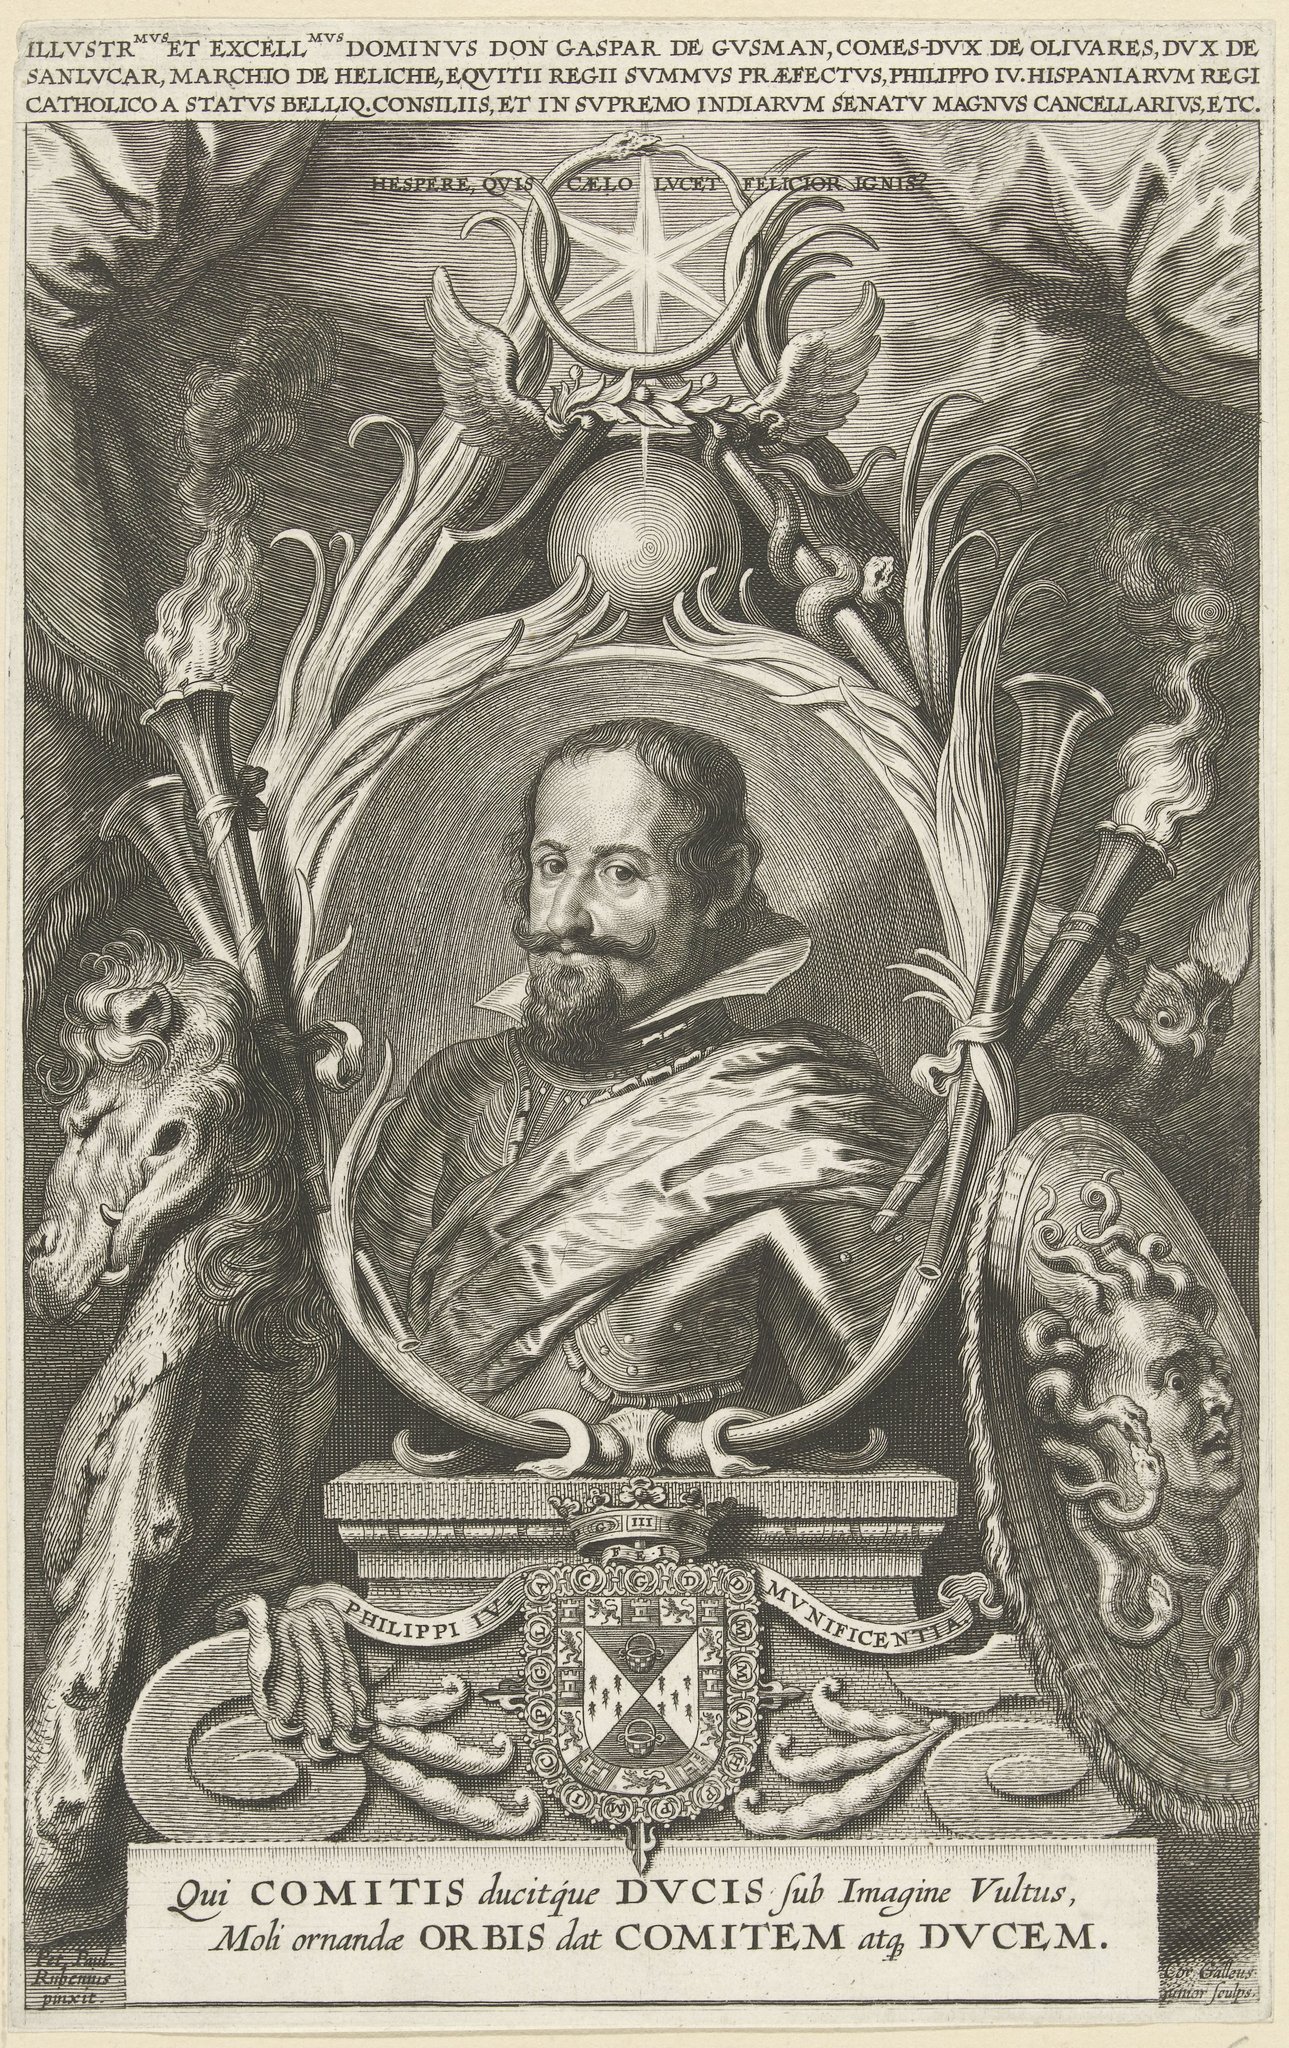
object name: print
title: Portret van Gaspar de Gusmán, graaf van Olivares, hertog van St. Lucar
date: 1638-1650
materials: paper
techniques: engraving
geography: antwerp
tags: gaspard de gusmán (graaf van olivares, hertog van san lucar)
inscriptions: collector's mark: Lugt 240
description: Portret van Gaspar de Gusmán in een allegorische omlijsting met fakkels, een uil en palmbladeren. Links de knots en de leeuwenhuid van Hercules, rechts een wapenschild met het hoofd van Medusa. Onder het portret op een sokkel het wapen van Filips IV van Spanje.